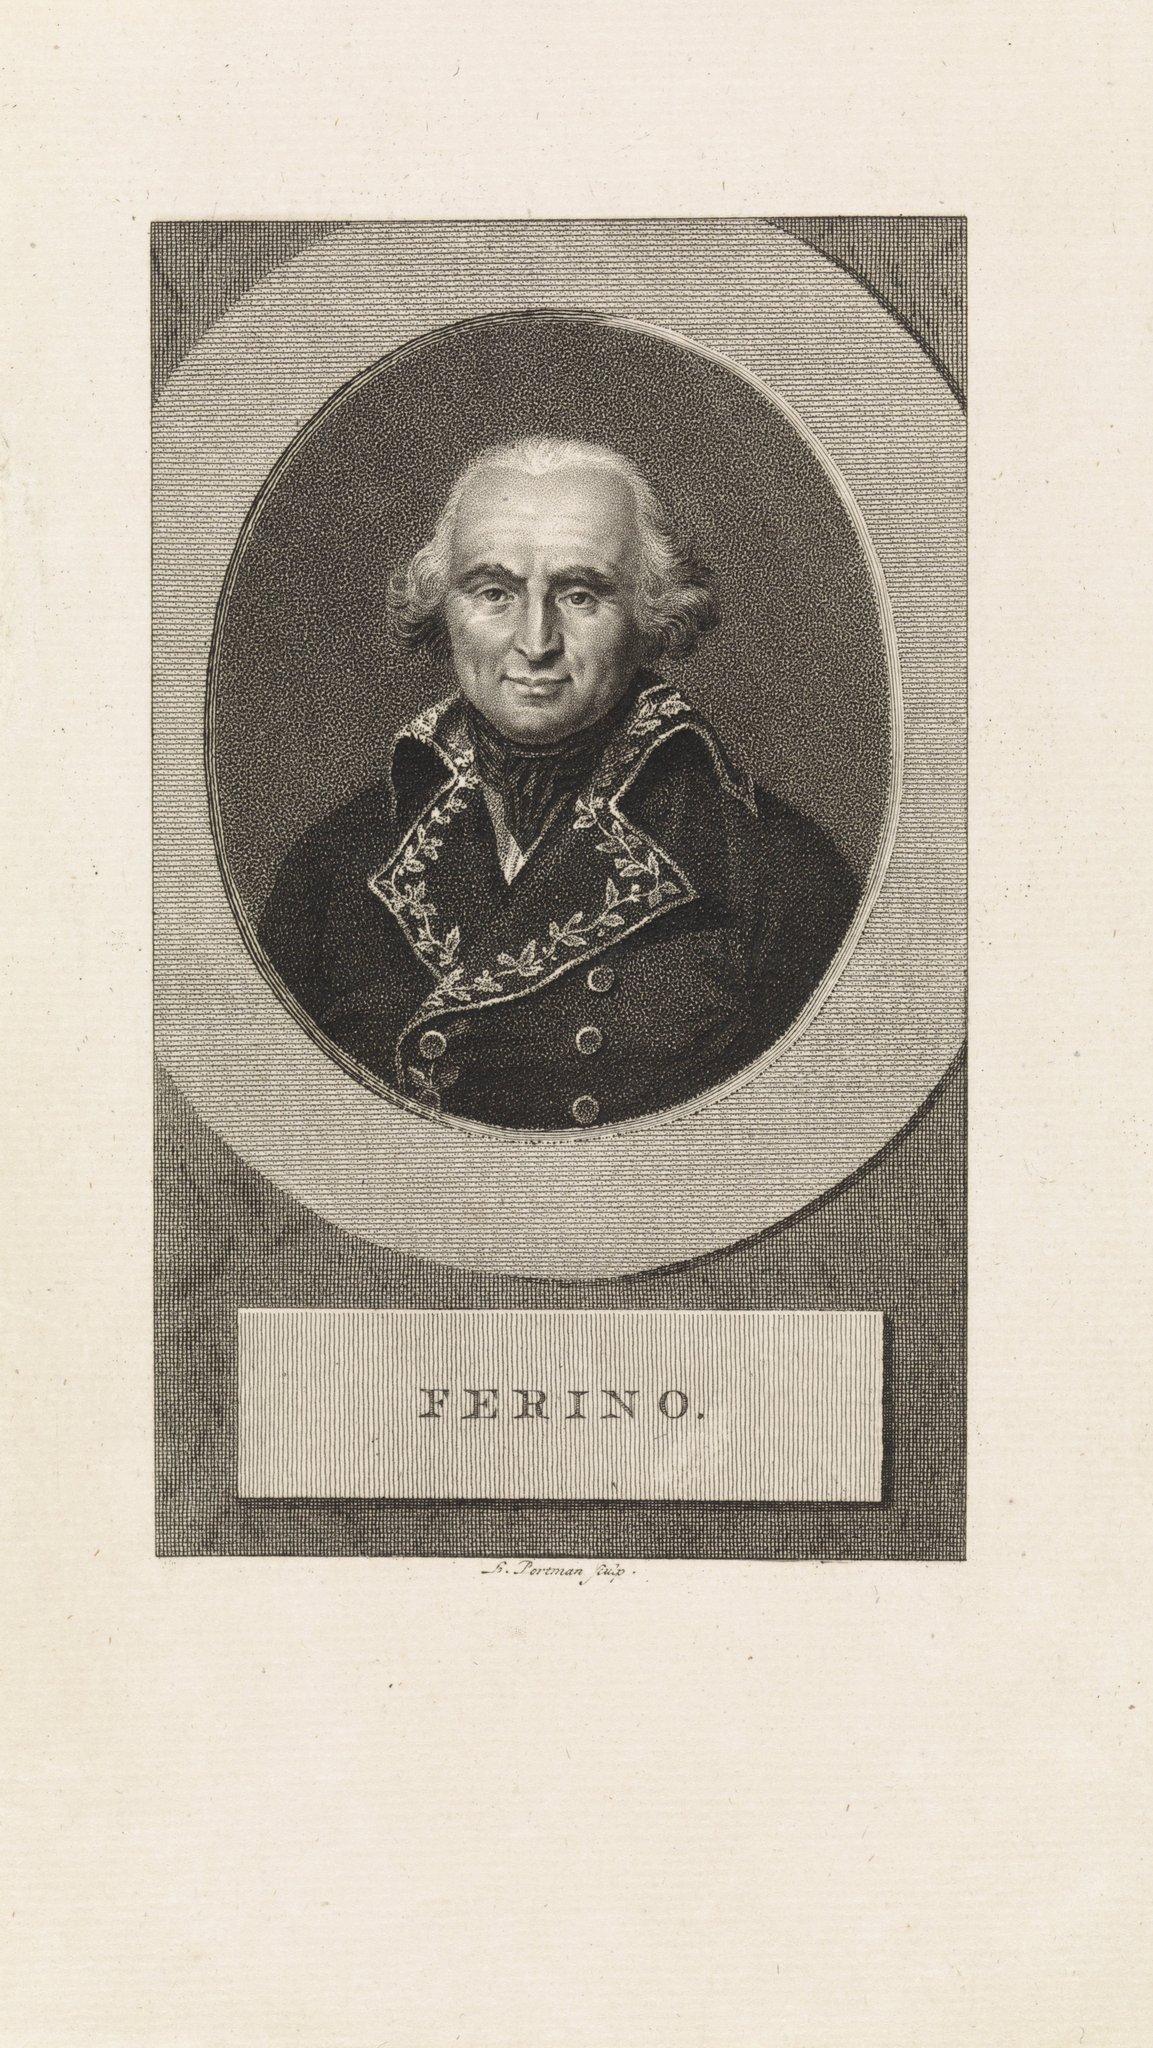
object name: print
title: Portret van de Franse generaal Pierre Marie Barthélemy Ferino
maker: ludwig gottlieb portman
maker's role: print maker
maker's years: 1772-1828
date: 1806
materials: paper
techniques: stippled etching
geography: amsterdam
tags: craveggia, generaal, pierre marie barthélemy ferino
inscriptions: collector's mark: Lugt 2228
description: Prent ook gebruikt als illustratie in: Tafereelen van de staatsomwenteling in Frankrijk, deel 22, p. 218. Amsterdam: Johannes Allart, 1806.